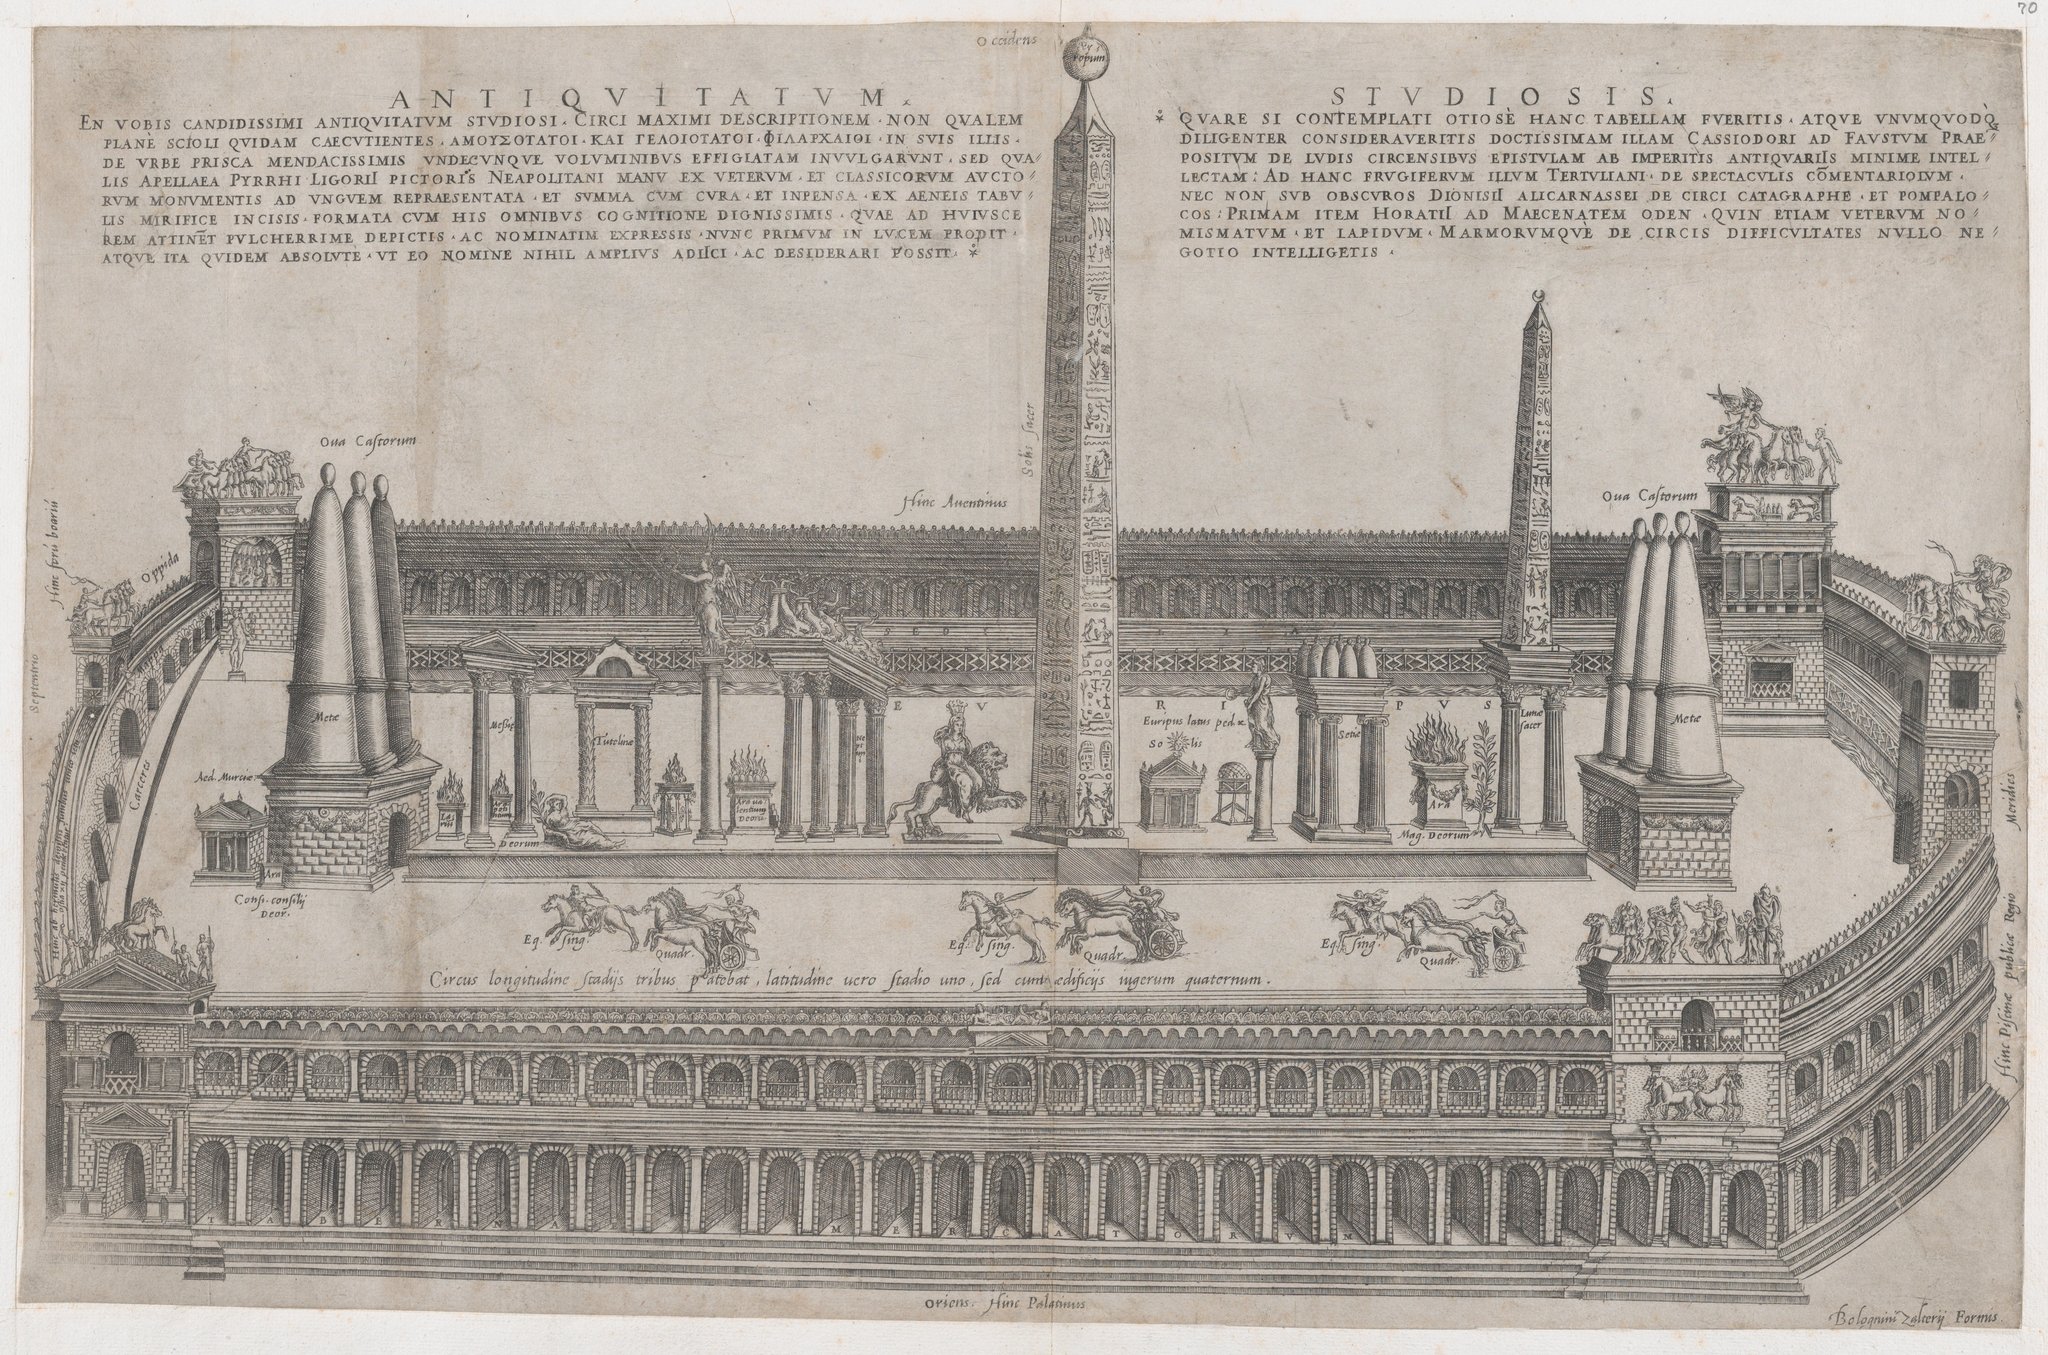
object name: print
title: Circus Maximus, from "Speculum Romanae Magnificentiae"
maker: Anonymous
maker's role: artist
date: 1553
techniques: engraving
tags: amphitheatres,obelisks,horses,lions,rome